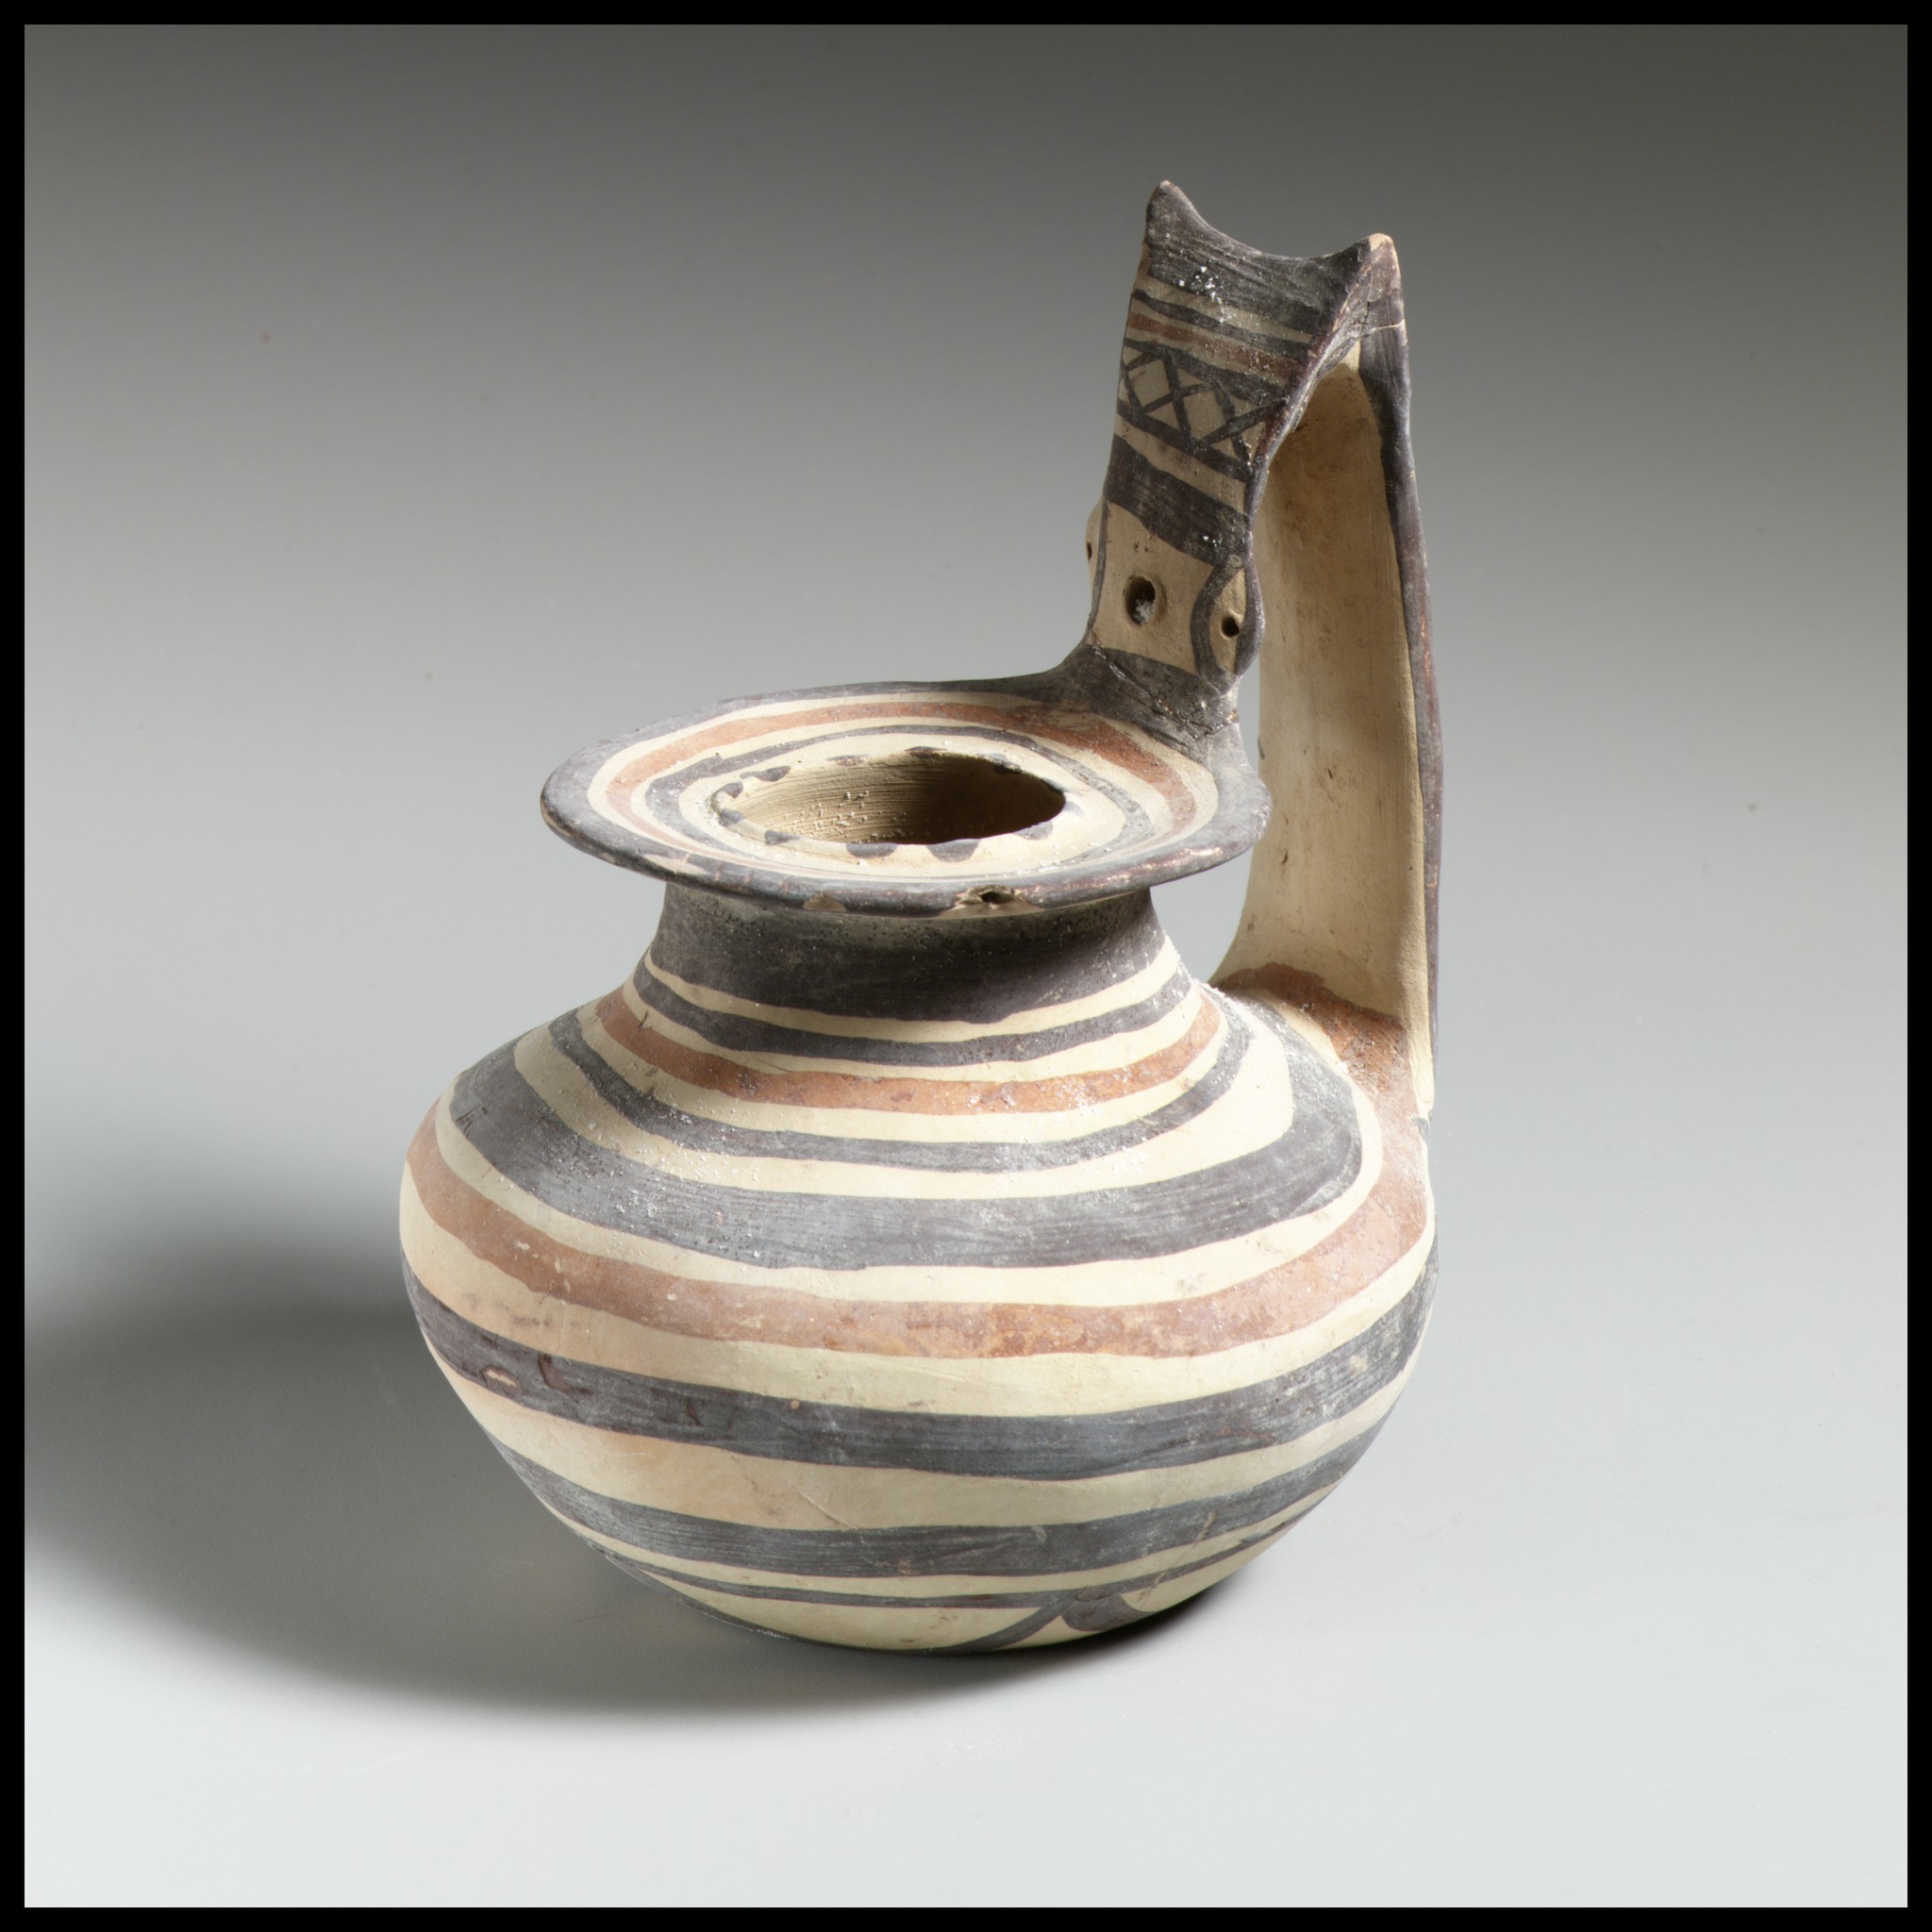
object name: jug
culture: italic, daunian or south italian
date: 900-100 BCE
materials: terracotta